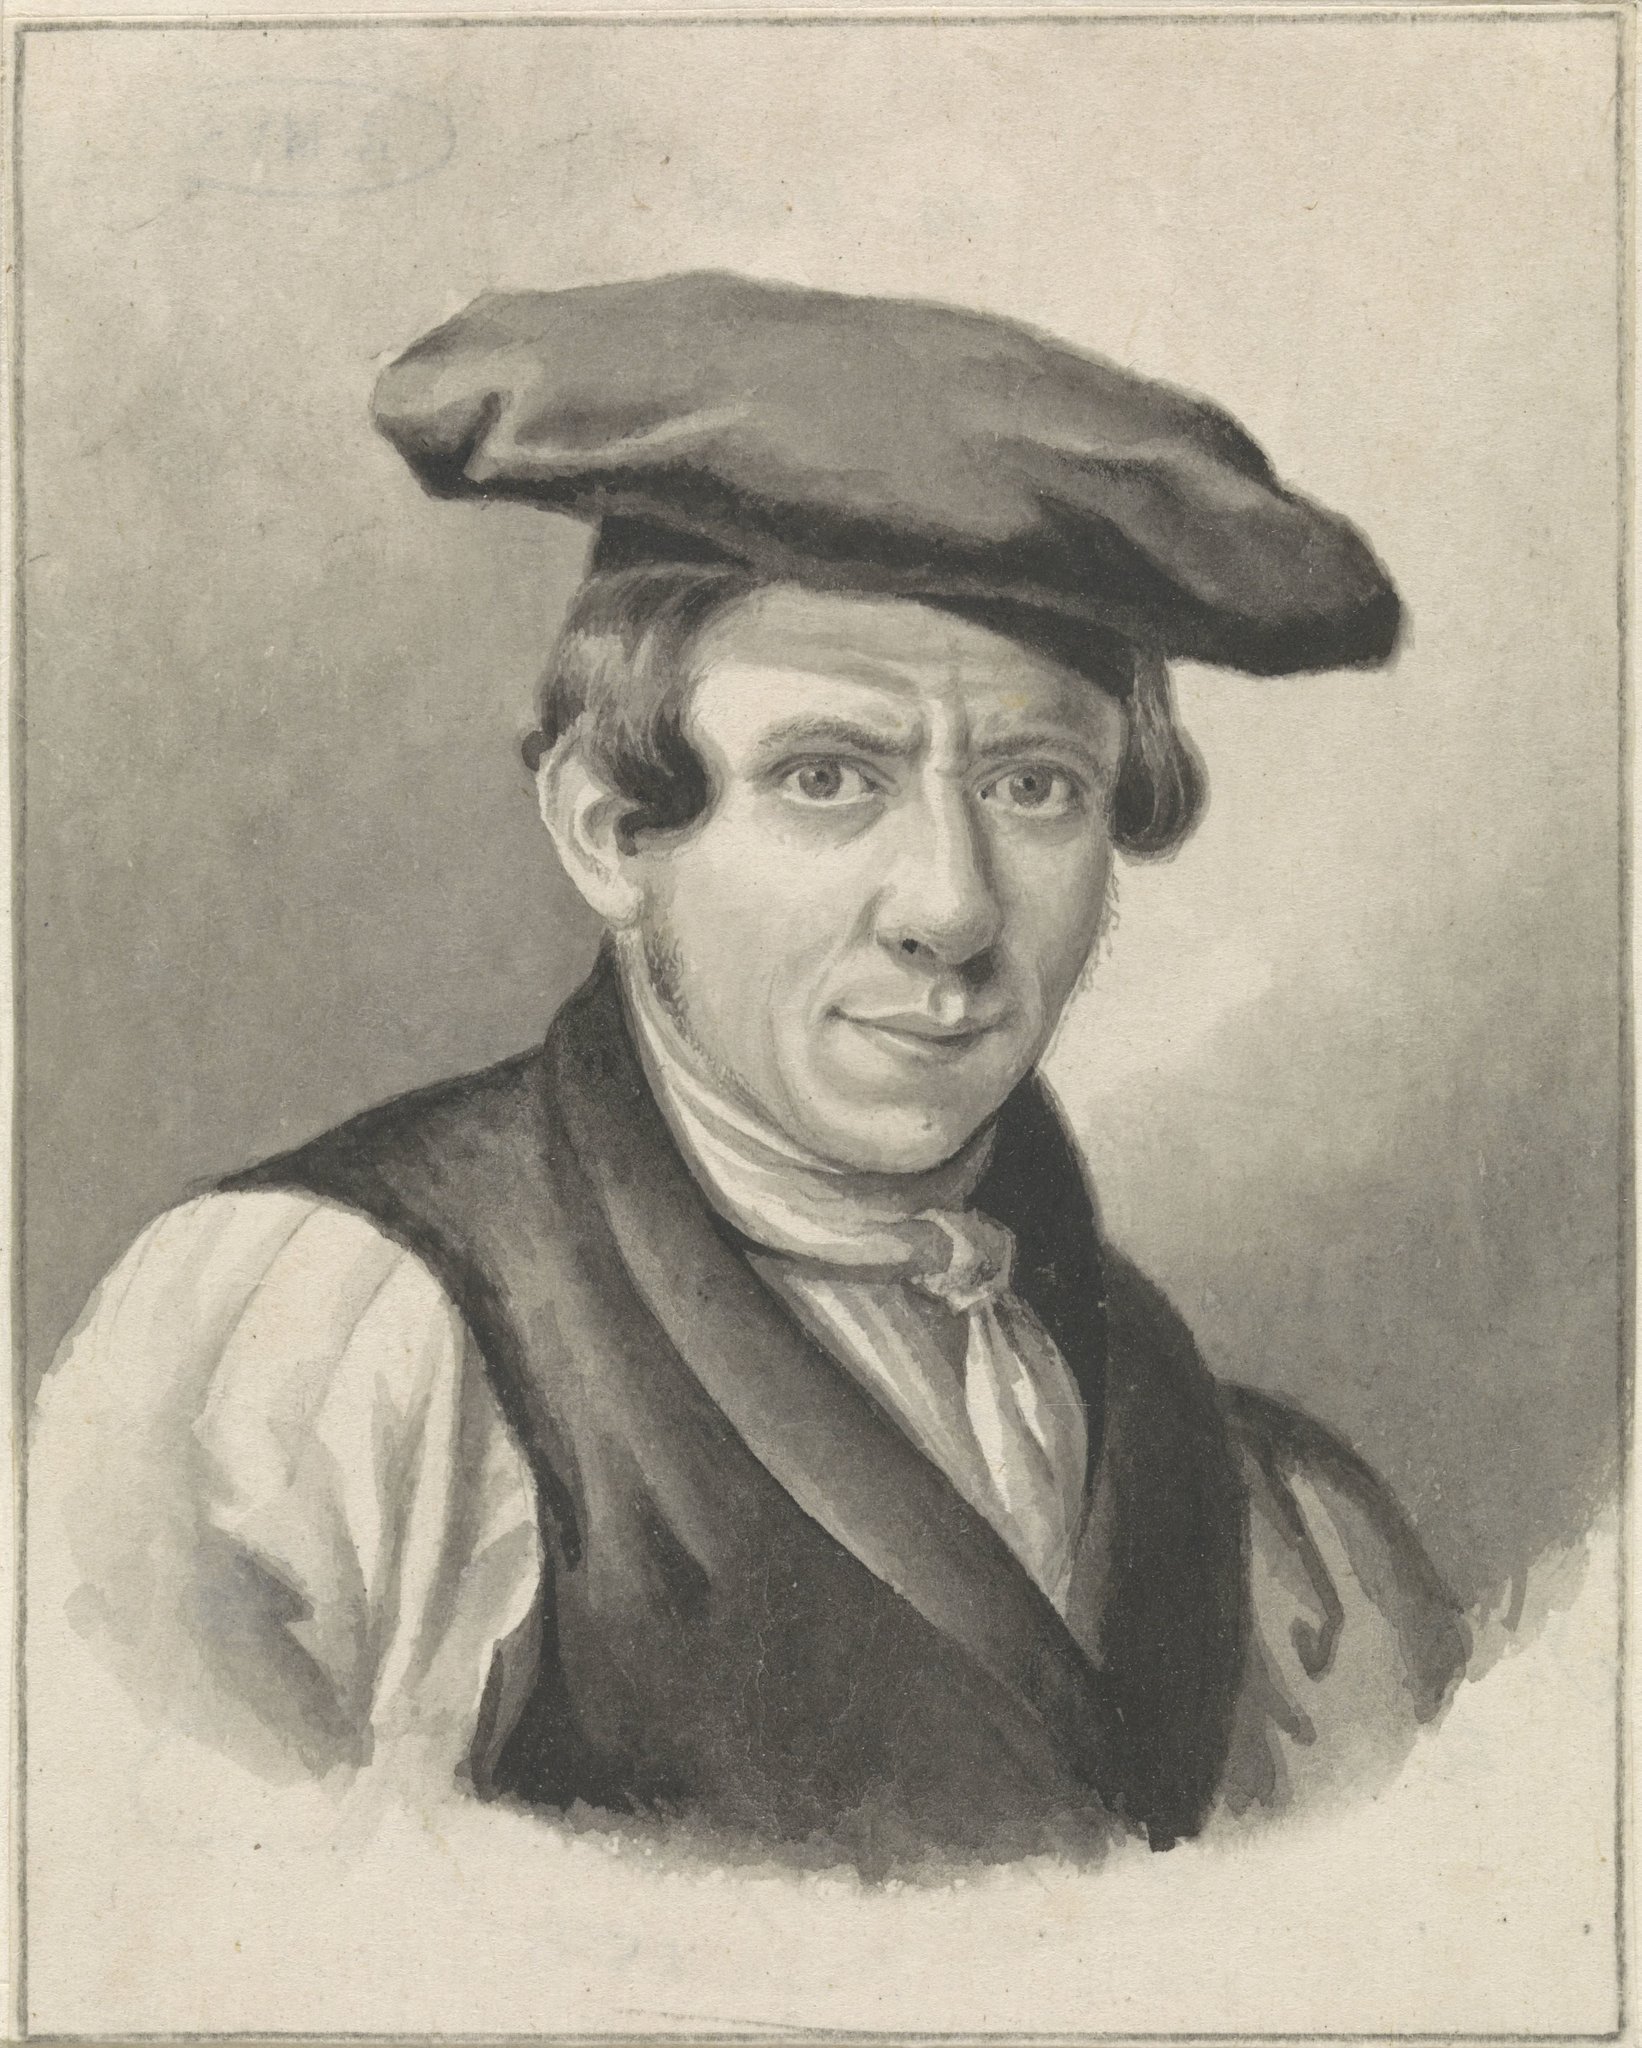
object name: drawing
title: Zelfportret van Johannes Boshamer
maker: johannes boshamer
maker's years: 1800-1852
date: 1825-1852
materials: ink, paper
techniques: brush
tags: dordrecht, johannes boshamer, historical persons, portrait, self-portrait of painter, portrait, self-portrait of artist, portrait, self-portrait of draughtsman